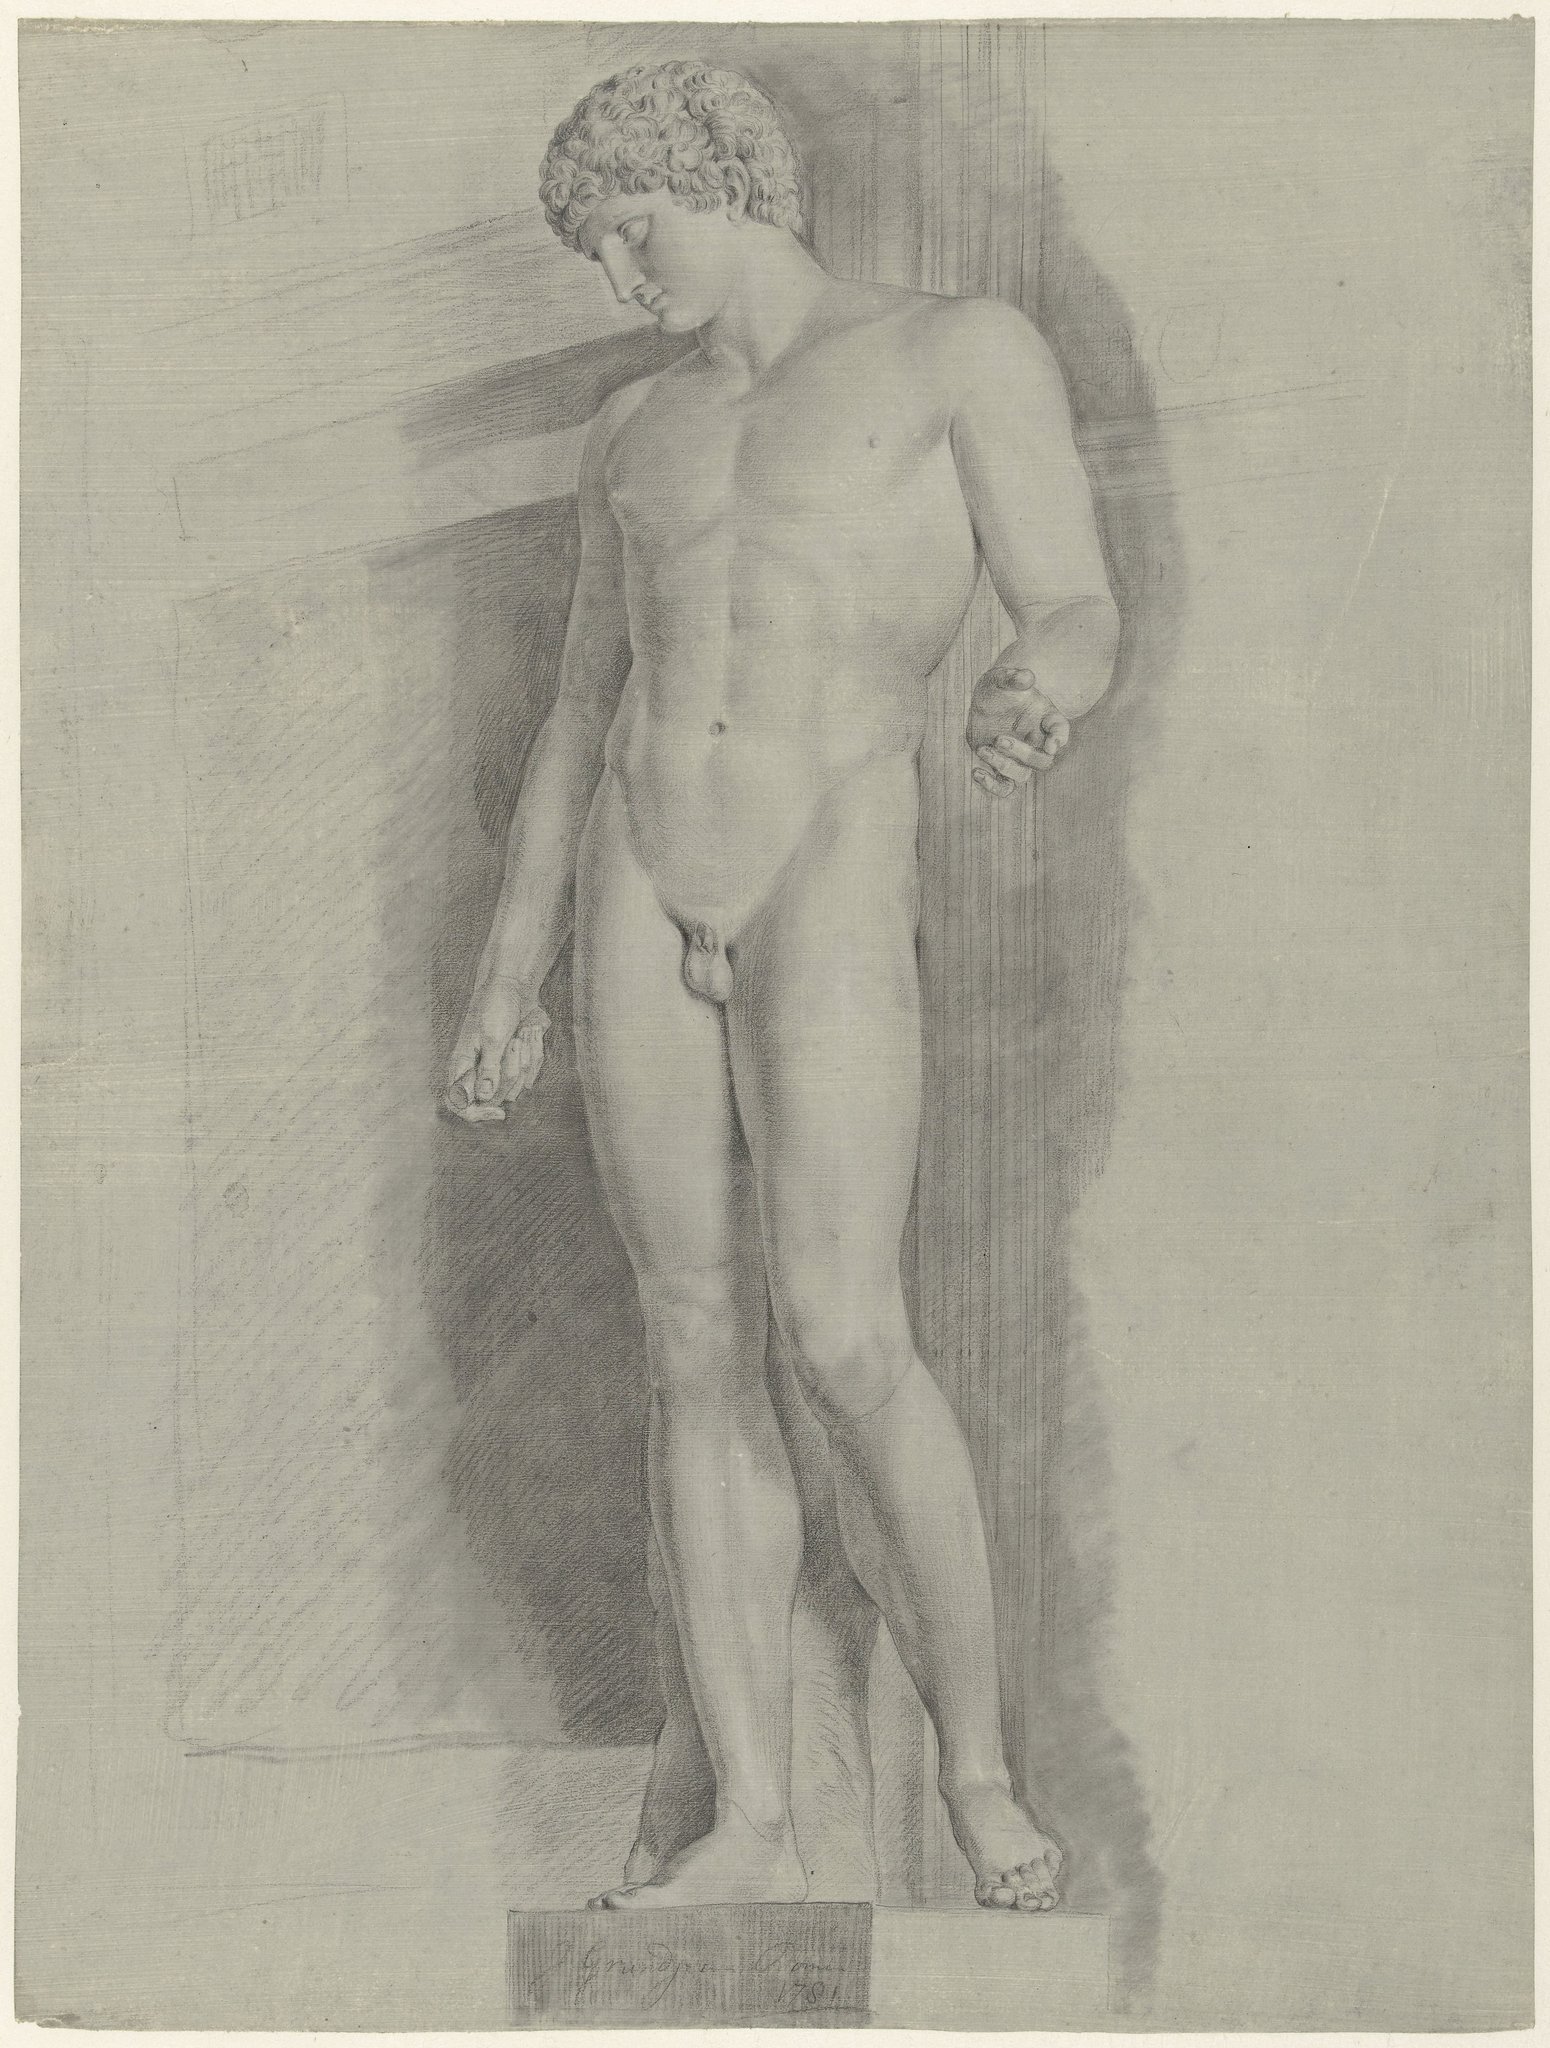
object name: drawing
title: Studie naar het standbeeld genaamd de Albani Antinous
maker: jean grandjean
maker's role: draughtsman, print maker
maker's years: 1752-1781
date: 1781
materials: chalk, paper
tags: names of artefacts and man-made objects (buildings excluded), piece of sculpture, reproduction of a piece of sculpture